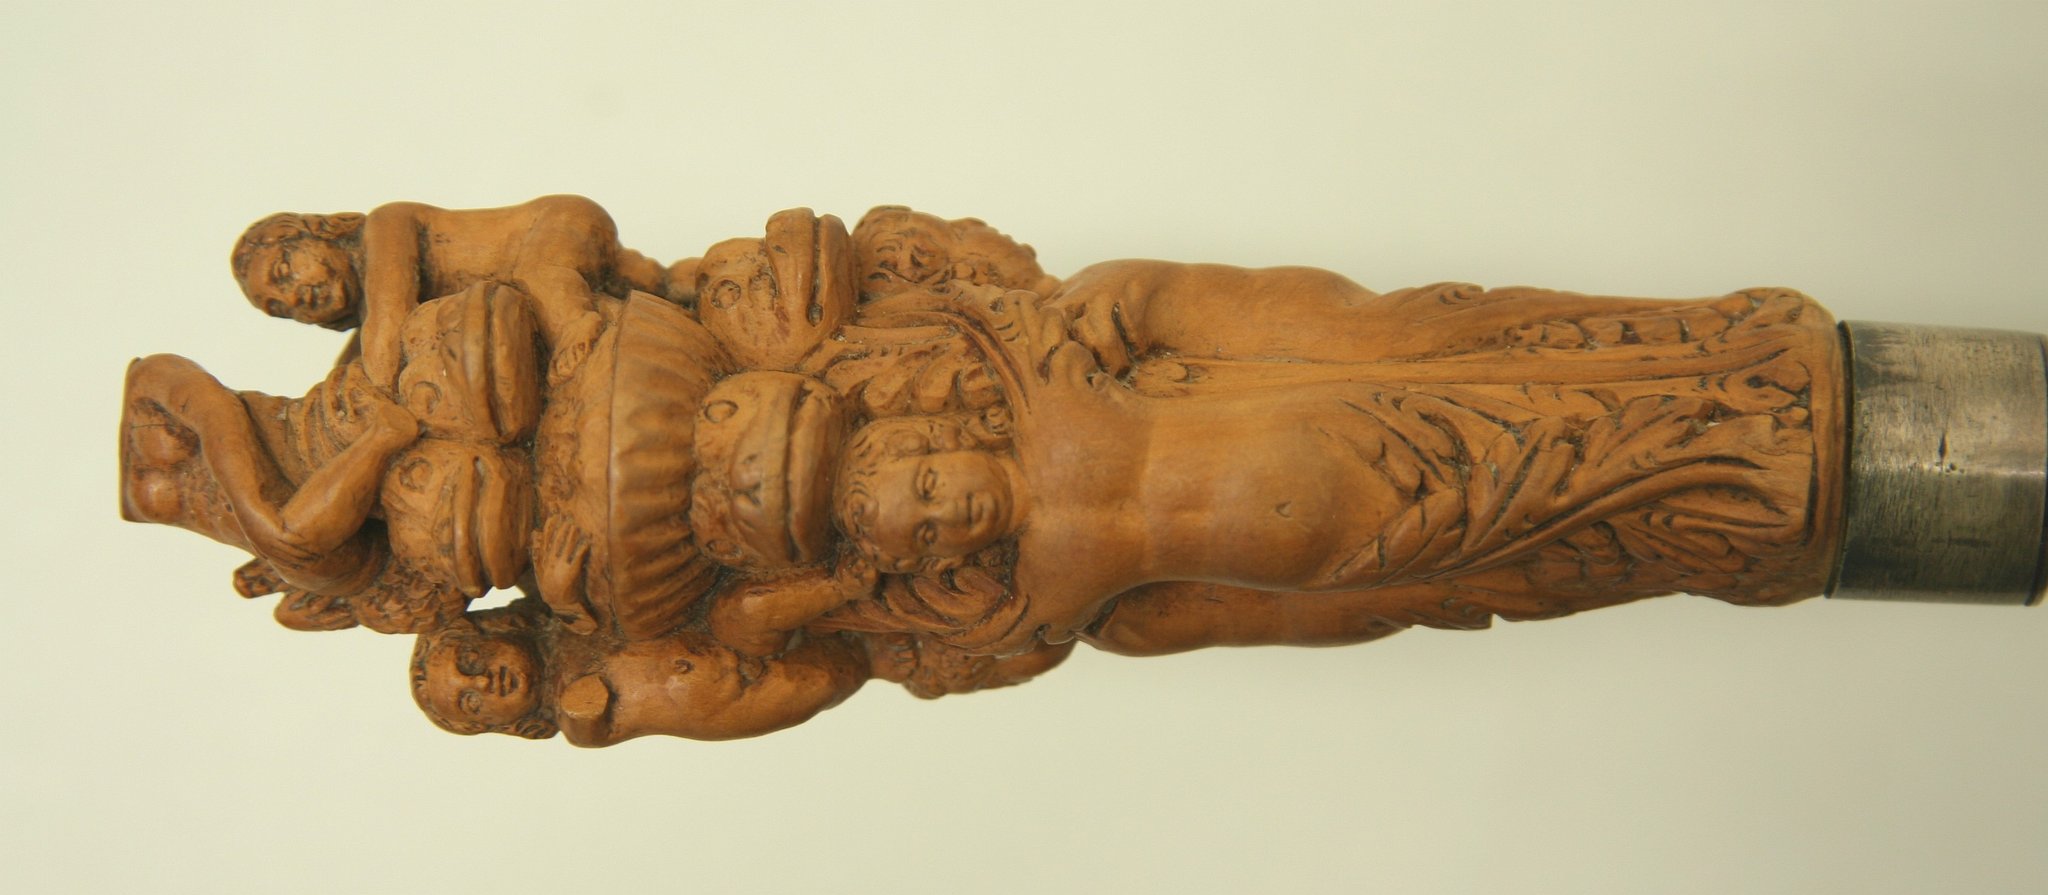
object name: fork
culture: italian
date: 1601-1700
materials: wood, silver, steel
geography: italy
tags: putti